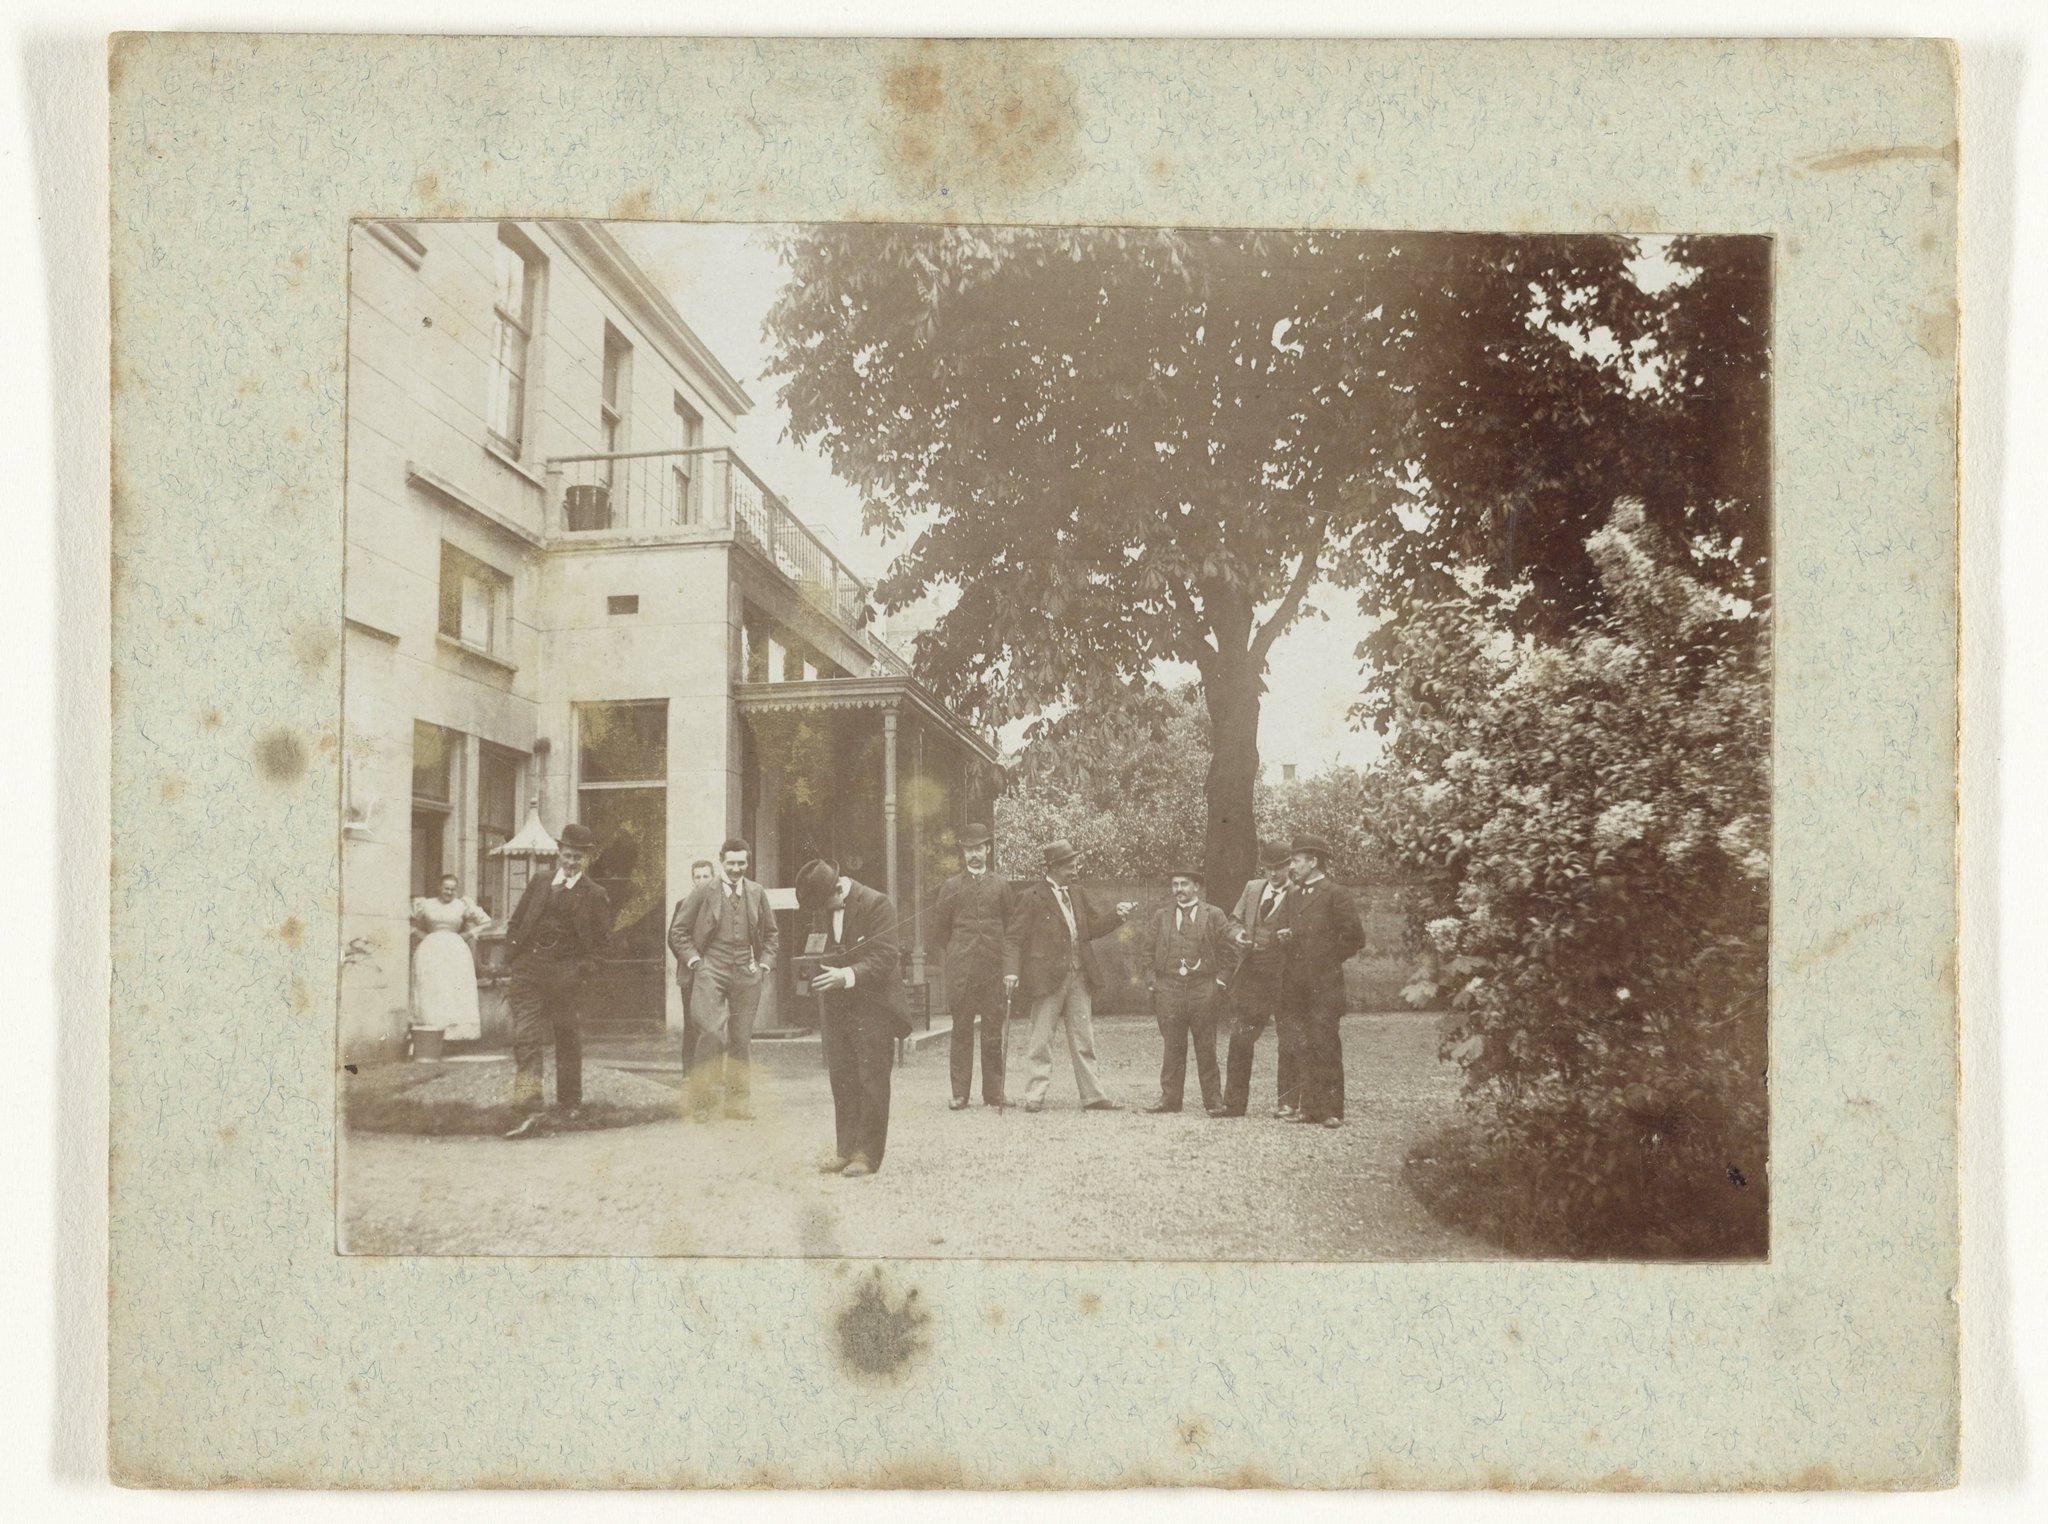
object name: photograph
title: Negen jonge mannen op het erf bij een huis, op de voorgrond een amateurfotograaf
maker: g.j. niekerk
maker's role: amateurfotograaf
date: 1890-1910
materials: paper, cardboard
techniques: gelatin silver print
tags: photographer at work - cc - out of doors, youth, adolescent